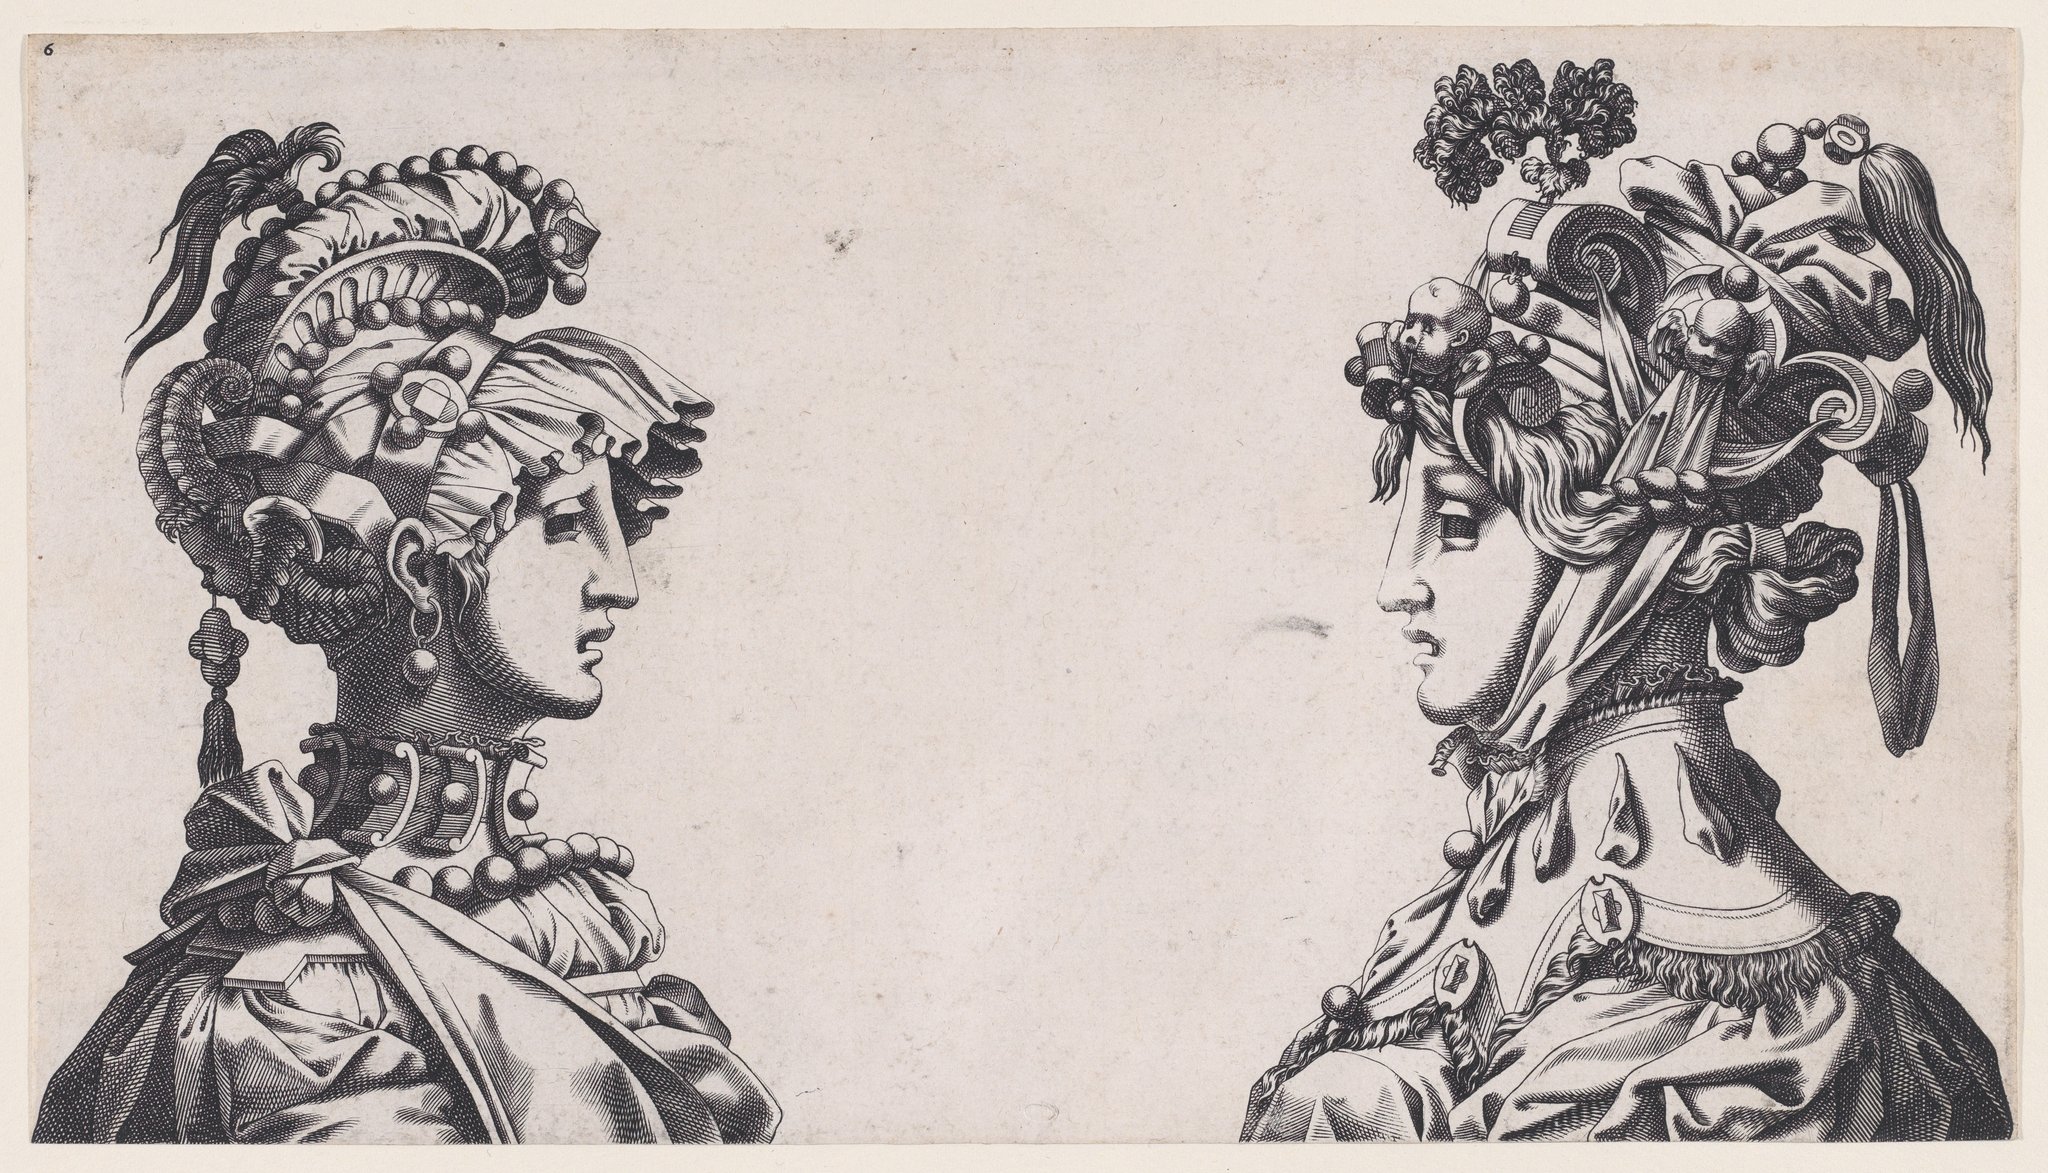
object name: print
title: Fantastical Masked Female Heads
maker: rené boyvin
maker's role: artist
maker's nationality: french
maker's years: 1525-1598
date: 1525-1600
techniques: engraving